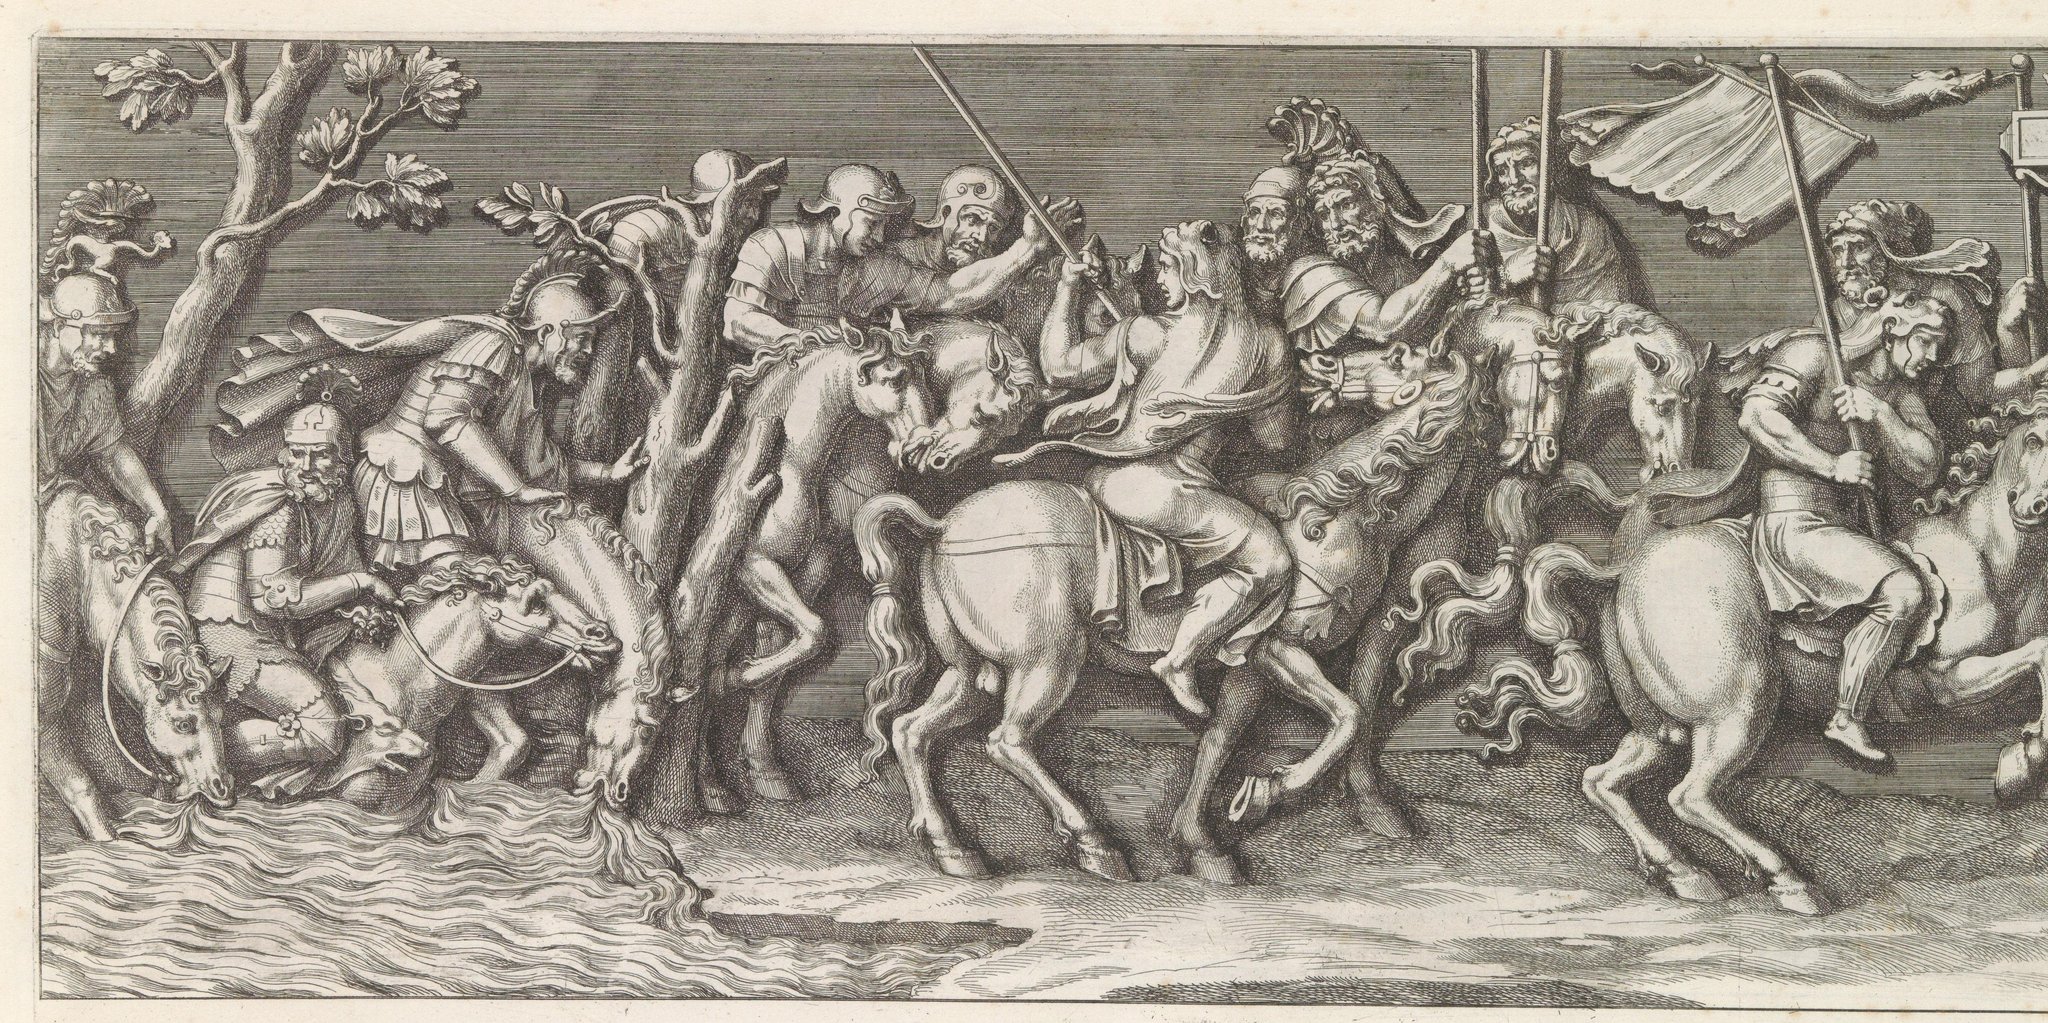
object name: print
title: Triomftocht van keizer Sigismund I in 1432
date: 1680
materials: paper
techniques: etching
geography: mantua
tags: crossing a river, triumphal entry and public reception, pageant, 'entrée solennelle', 'joyeuse entrée', military parade, pageant, the soldier; the soldier's life, the soldier; the soldier's life (+ cavalry, horsemen)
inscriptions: number: ‘21’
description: Prent maakt deel uit van een reeks van 25 prenten (+ titelprent) naar het stucwerk door Giulio Romano en Francesco Primaticcio in de Sala degli Stucchi in Palazzo del Te te Mantua.